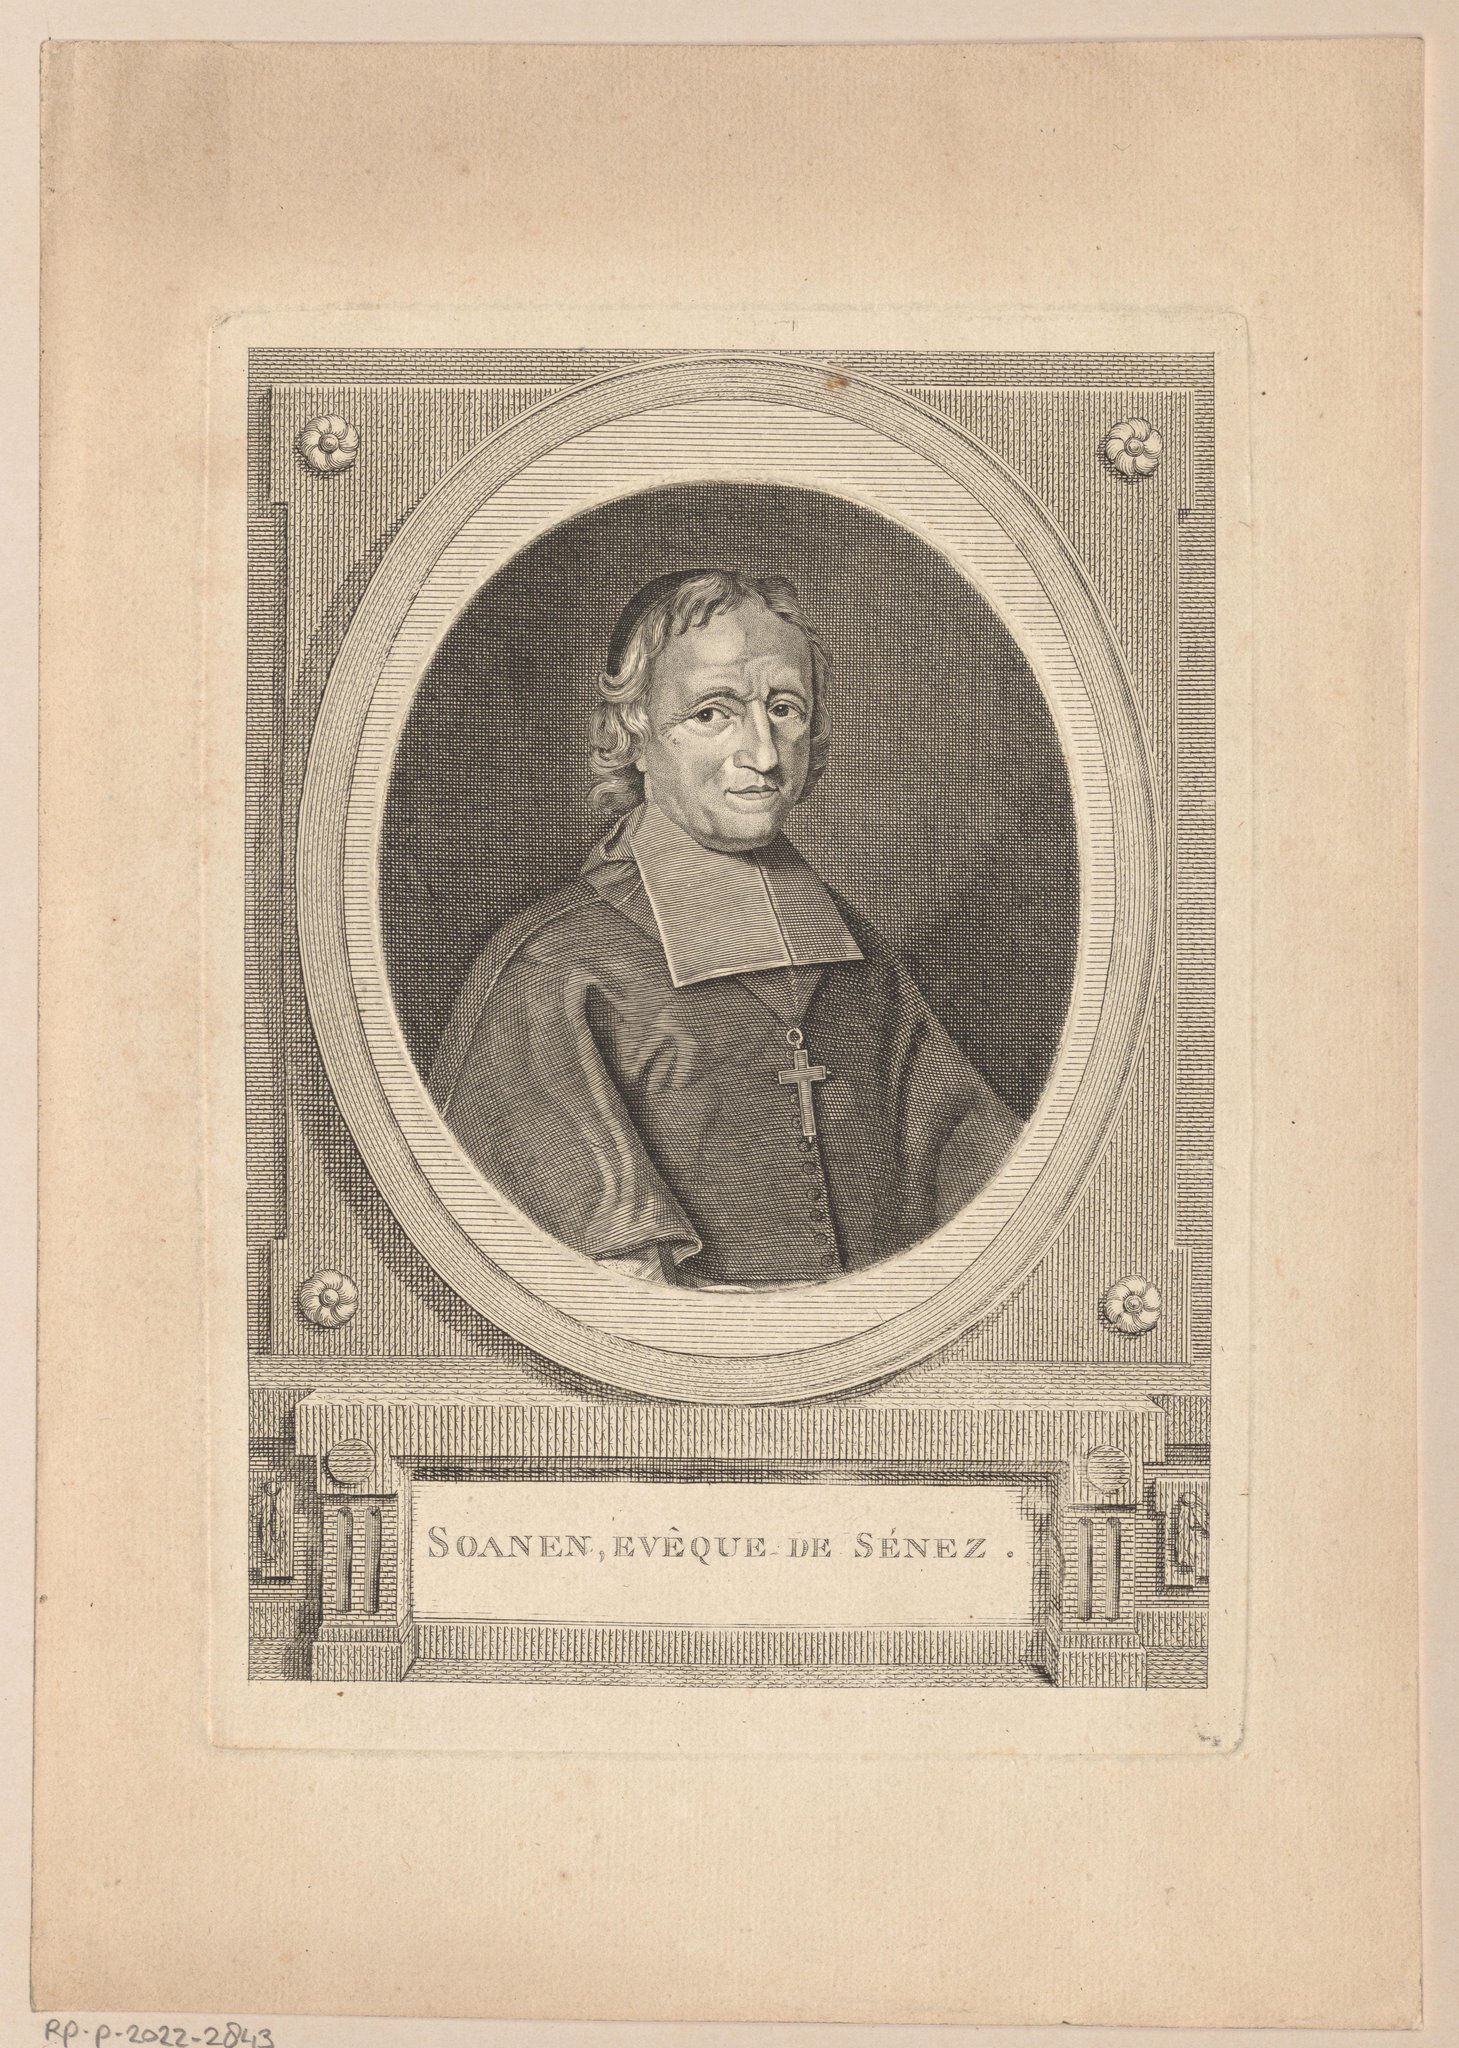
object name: print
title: Portret van Jean Soanen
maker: Anonymous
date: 1695-1799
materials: paper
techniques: engraving, etching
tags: archbishop, bishop, etc. (roman catholic), historical persons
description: Met eenregelig onderschrift in het Frans.